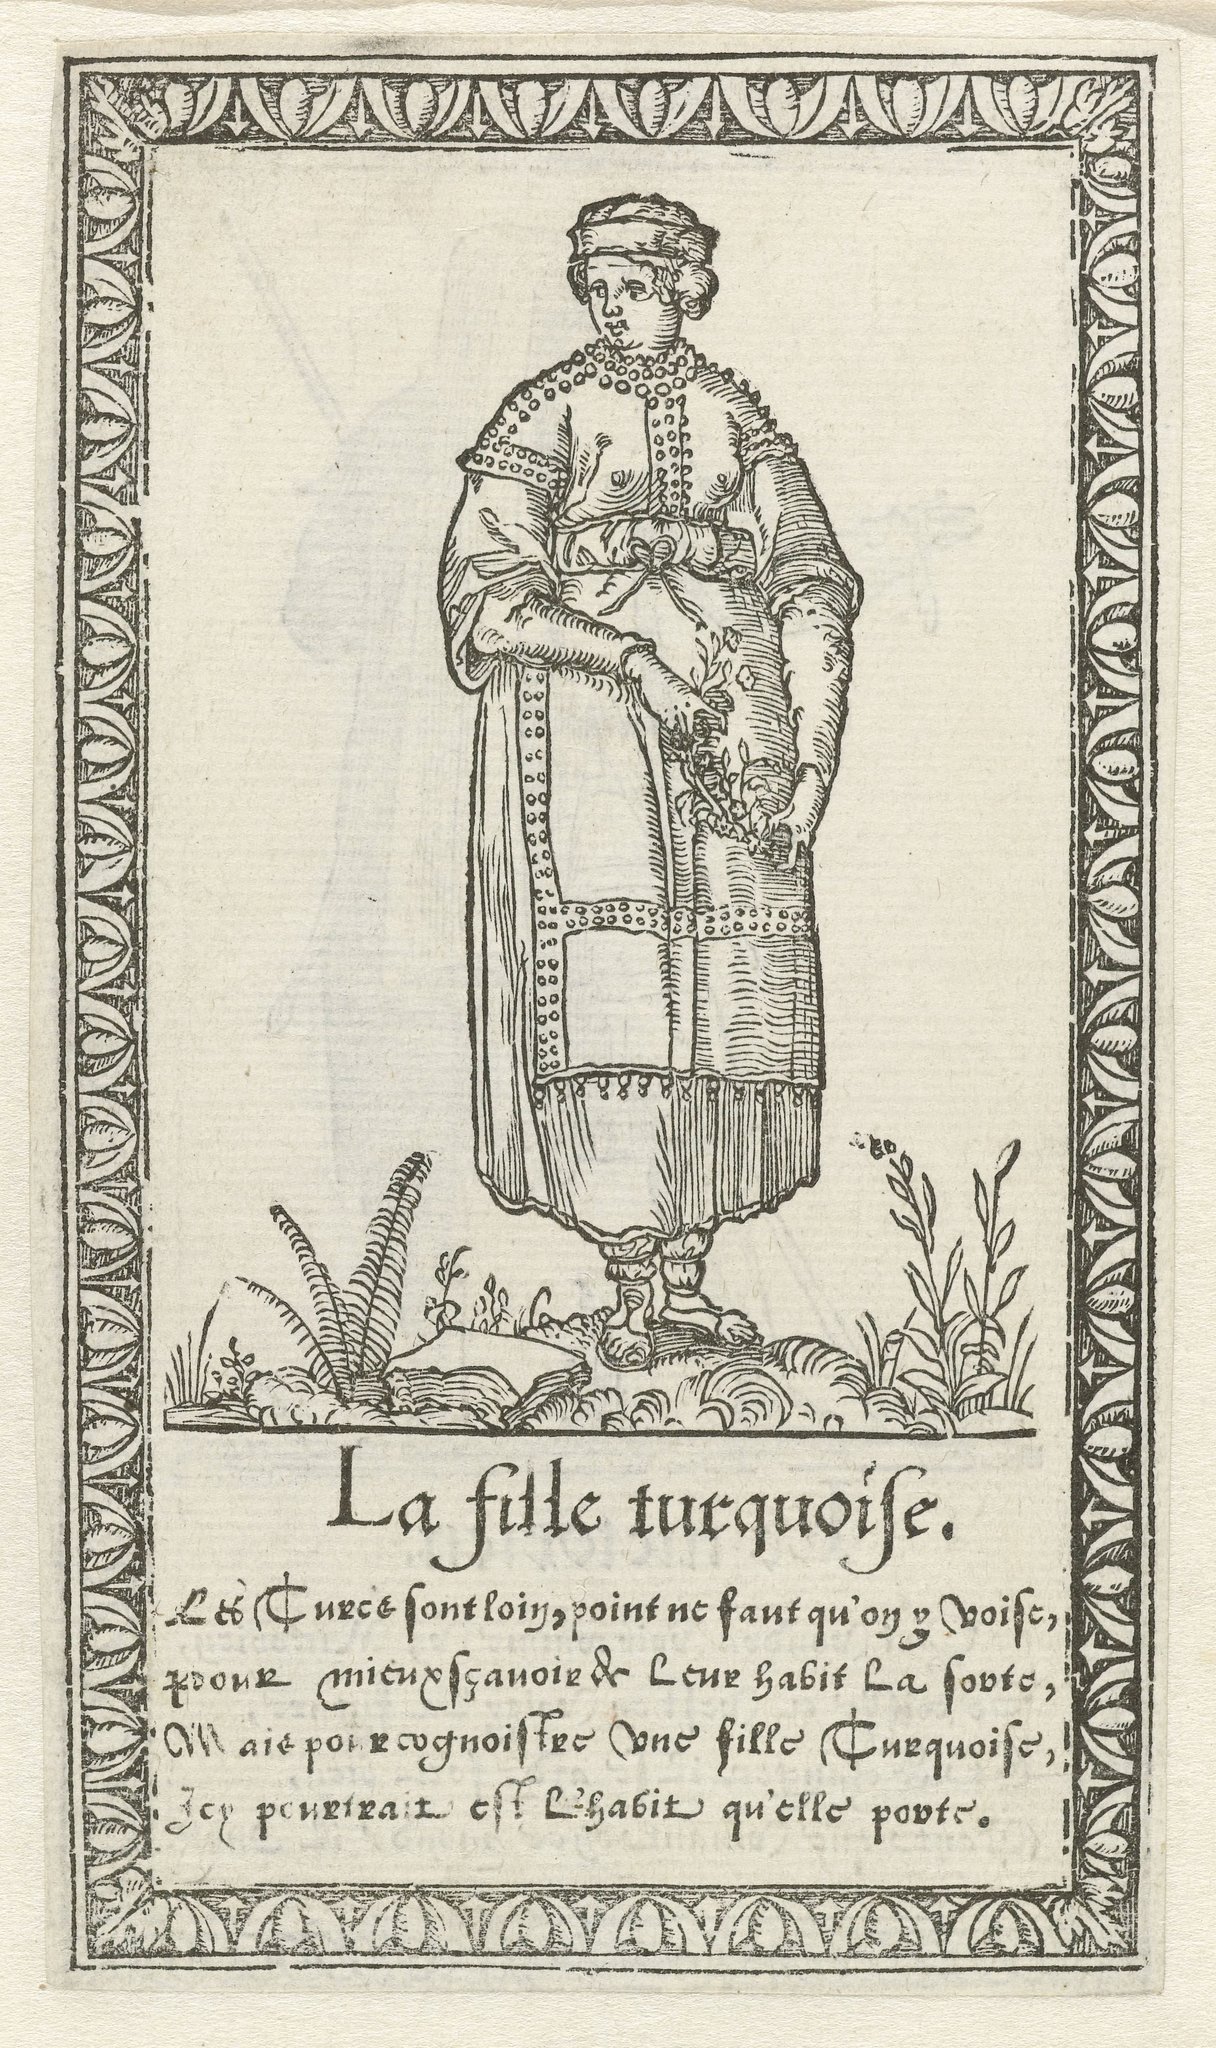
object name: print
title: La fille turquoise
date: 1562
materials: paper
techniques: woodcut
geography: paris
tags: asiatic races and peoples (+ costume), fashion plates, folk costume, regional costume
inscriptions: collector's mark: Lugt 2228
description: Dit is prent 108 uit een serie van 121. Binnen deze serie zijn er prenten gemaakt naar voorbeelden van Jean-François de Roberval en Enea Vico, onbekend welke precies.